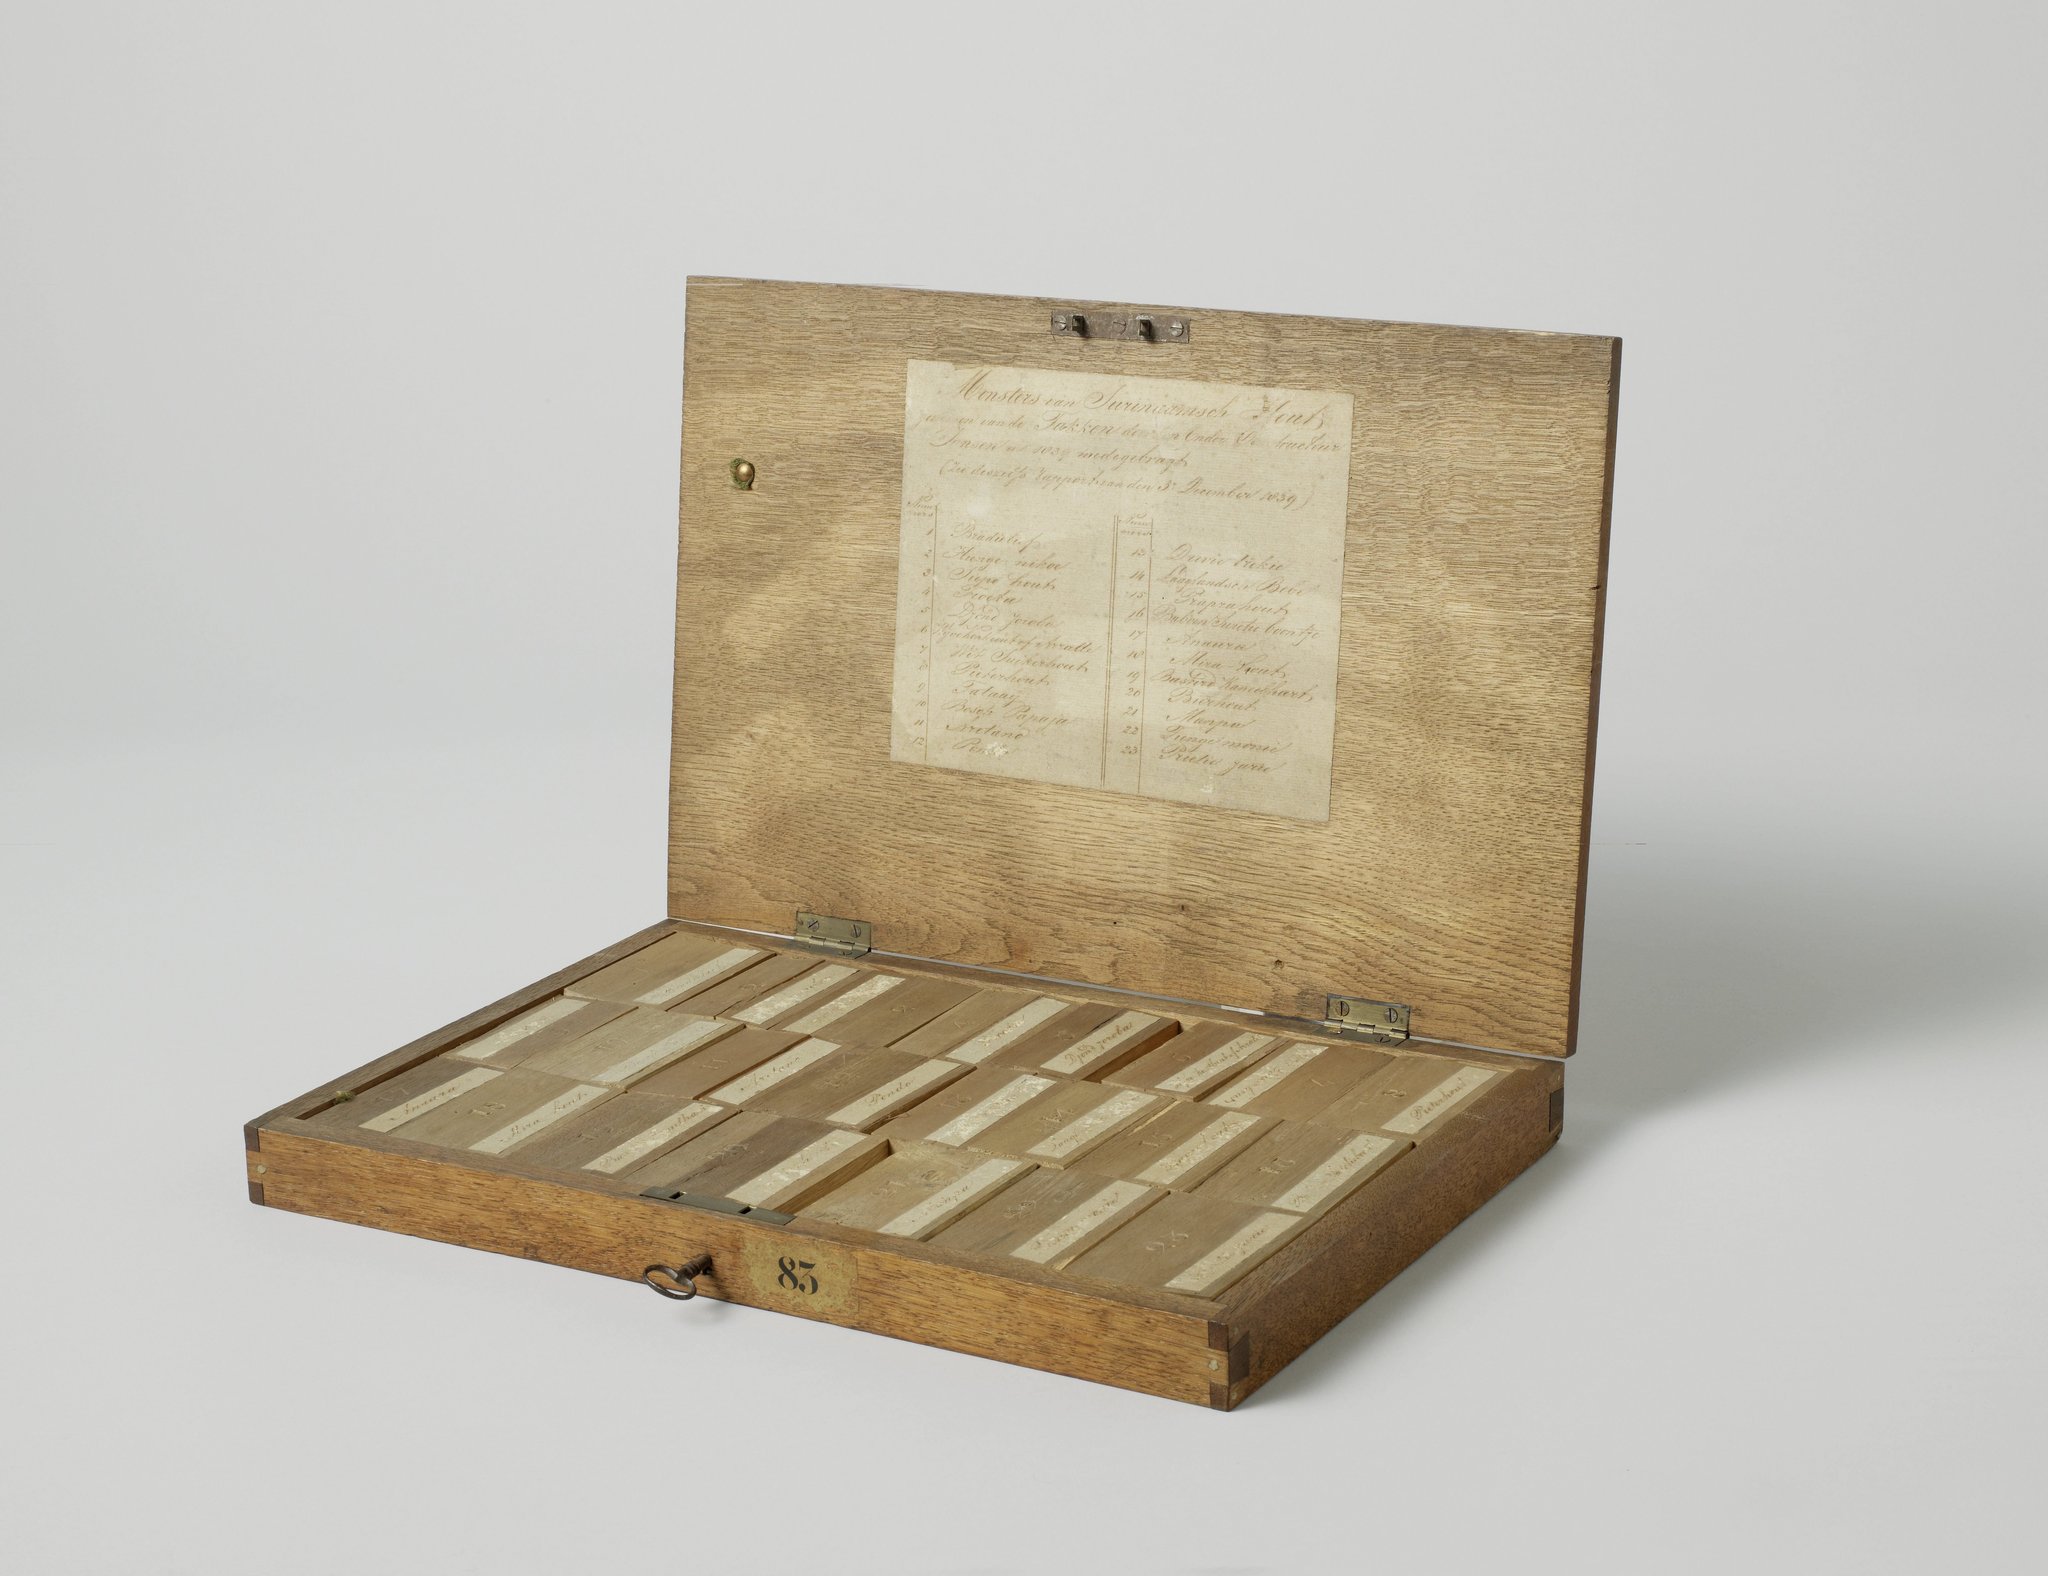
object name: wood block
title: Box Containing Twenty-Three Samples of Wood from Surinam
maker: p.f. jansen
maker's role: constructeur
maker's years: -1876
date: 1839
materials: copper, iron, paper, wood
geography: suriname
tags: suriname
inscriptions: label, on the box: ‘83’ former inventory label, inscription, on the inside of the lid: ‘Monsters van Surinaamsch Hout / genomen van de Takken door den Onder Constructeur / Jansen in 1839 medegebragt / (zie deszelfs rapport van den 3e December 1839) /’ list of the samples, inscription, on the samples: numbers and names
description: Rechthoekige doos met drie en twintig houtmonsters: 1. bradilief (genus Coccoloba, fam. Polygonoceae) 2. hienge nikoe (niet geïdentificeerd) 3. siepo (protium spec.) 4. troeta (niet geïdentificeerd) 5. djond joroba (niet geïdentificeerd) 6. arratte (minquartia guyanensis) 7. wit suikerhout (sugar pine of white maple) 8. pieterhout (niet geïdentificeerd) 9. tataai (niet gedentificeerd) 10. bosch papaja (niet geïdentificeerd) 11. aretano (niet geïdentificeerd) 12. pondo (niet geïdentificeerd) 13. drevie trekie (niet geïdentificeerd) 14. laaglandsche bebe (Pterocarpus draco) 15. praprahout (niet geïdentificeerd) 16. swietie boontje (Inga rubiginosa) 17. anaura (iengi-barki, Licania heteromorpha of doekoelia, Couepia surinamensis) 18. mirahout (Triplaris surinamensis) 19. bastaard kaneelhart (Acrodiclidium canella?) 20. bierhout (niet geïdentificeerd) 21. manpa (niet geïdentificeerd) 22. tienge monie (zie boven: siepo) 23. pritijari (Rutaceae spec.).